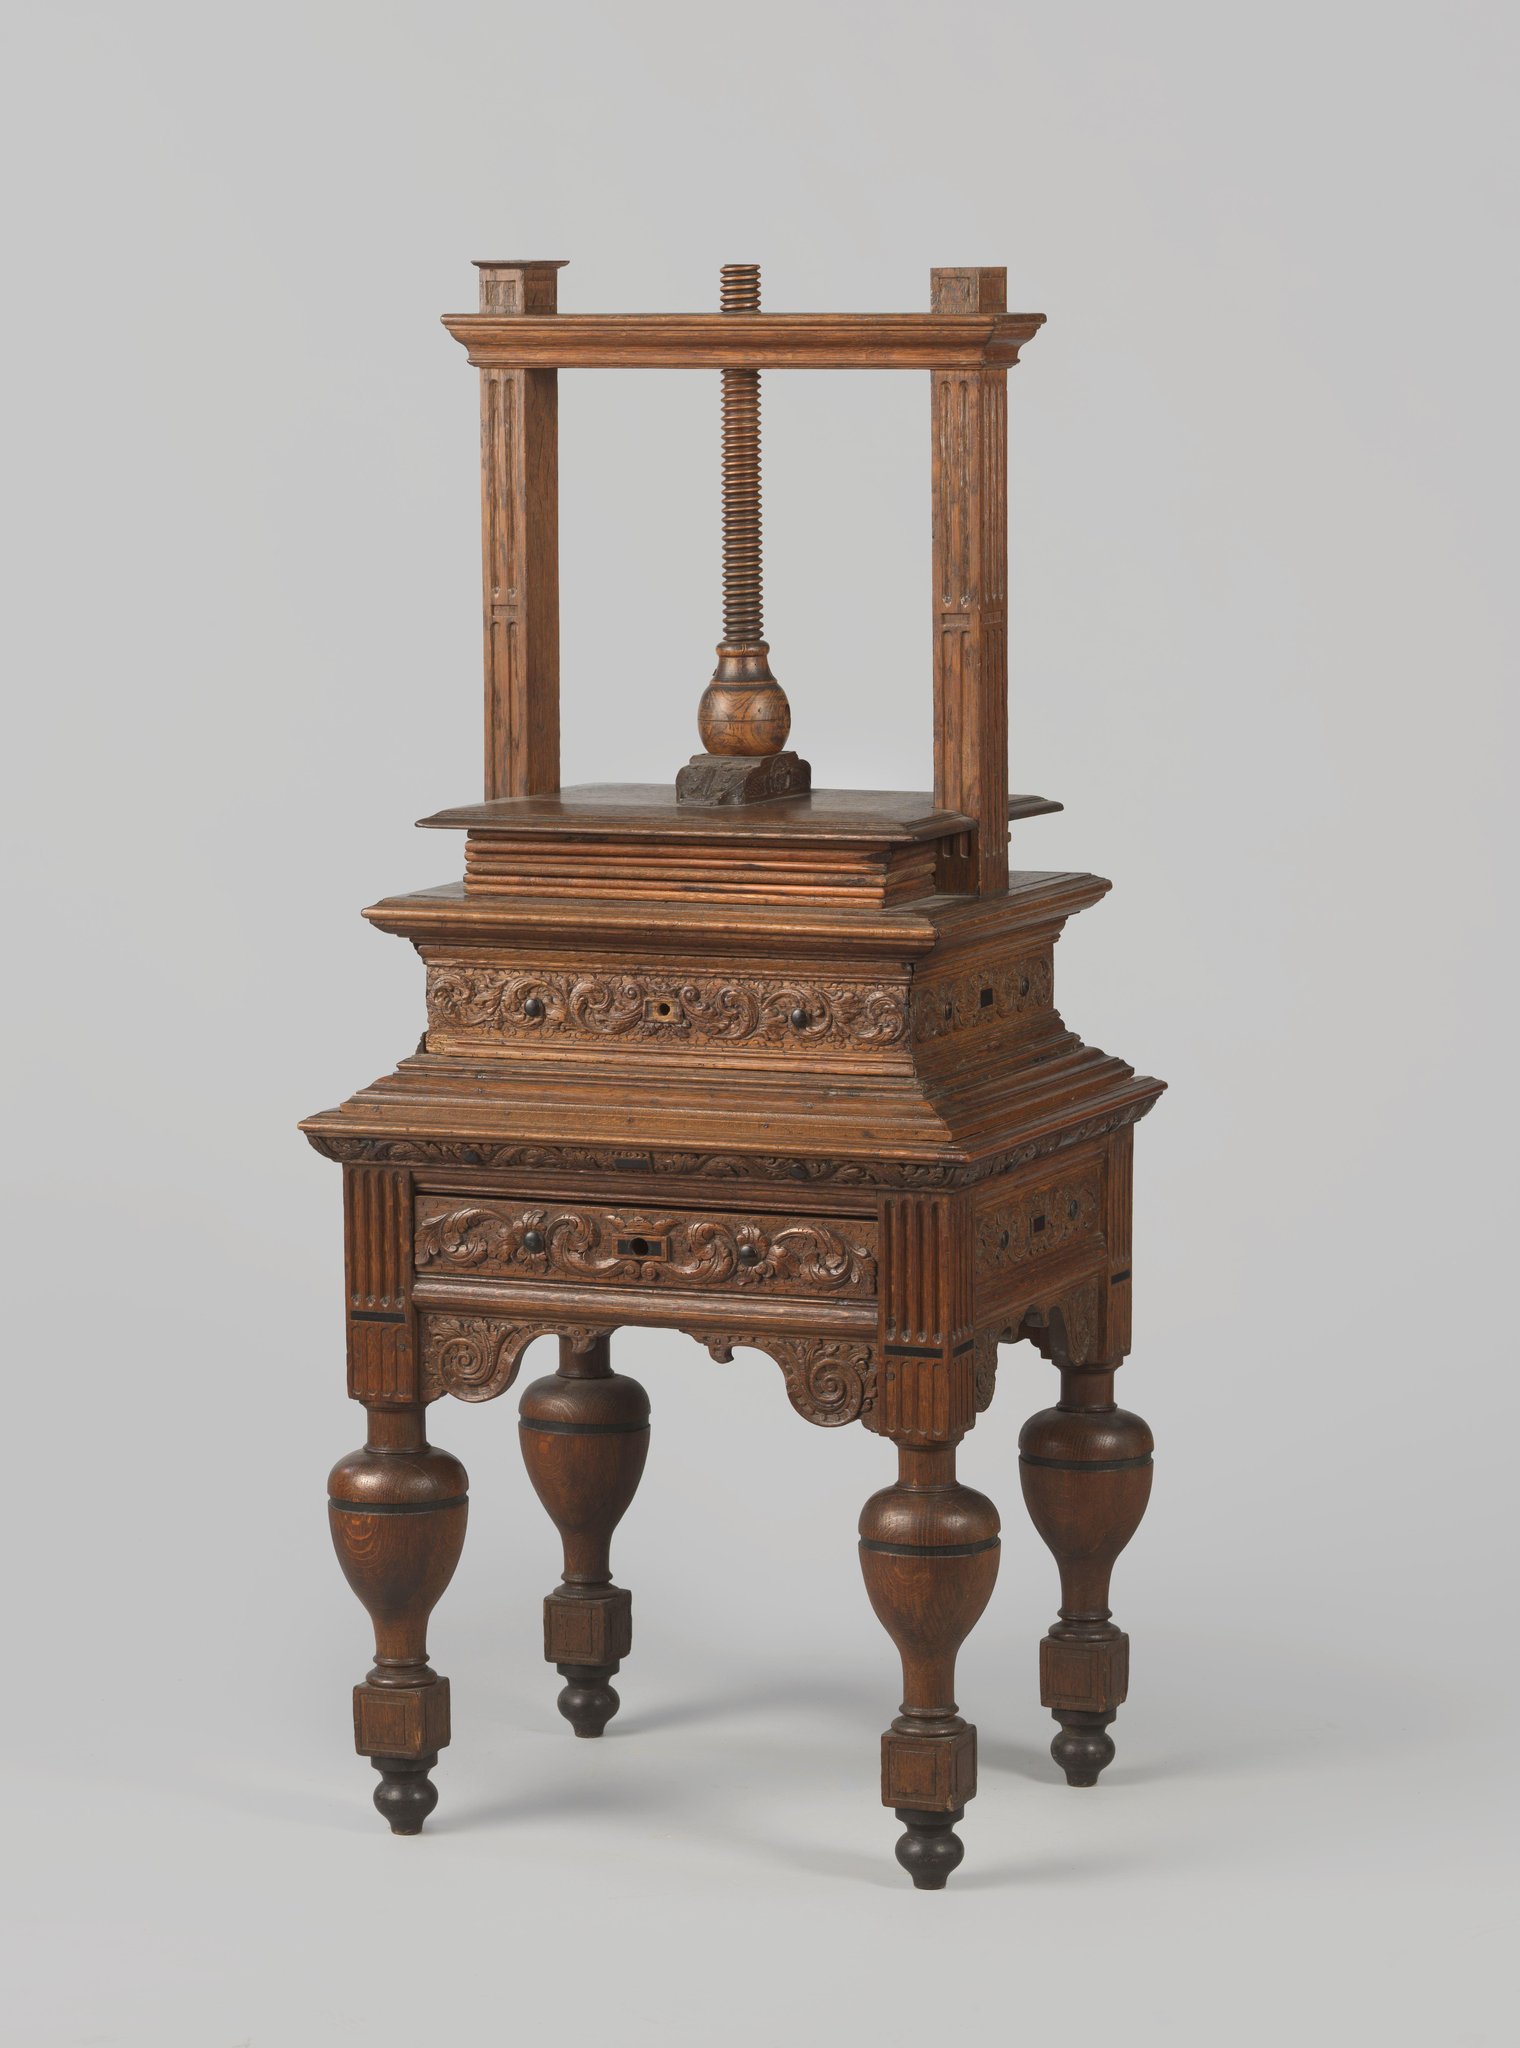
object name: press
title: Pers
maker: Anonymous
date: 1600-1650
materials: wood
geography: northern netherlands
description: Pers van eikenhout, op onderstel met vaaspoten die gecanneleerde huizen dragen. Het onderstel met lade heeft regels en een geprofileerde kroonlijst, versierd met gestoken bladranken en onderaan voluutvormige steunstukken. De gecanneleerde schavotstijlen staan op een voetstuk met lade, versierd met bladranken, en zij worden bekroond door gedraaide vazen. De spil eindigt in een peervormige taats, waar de knevel doorheen gaat, en in een versierd steunstuk. De pers heeft zes bladen.